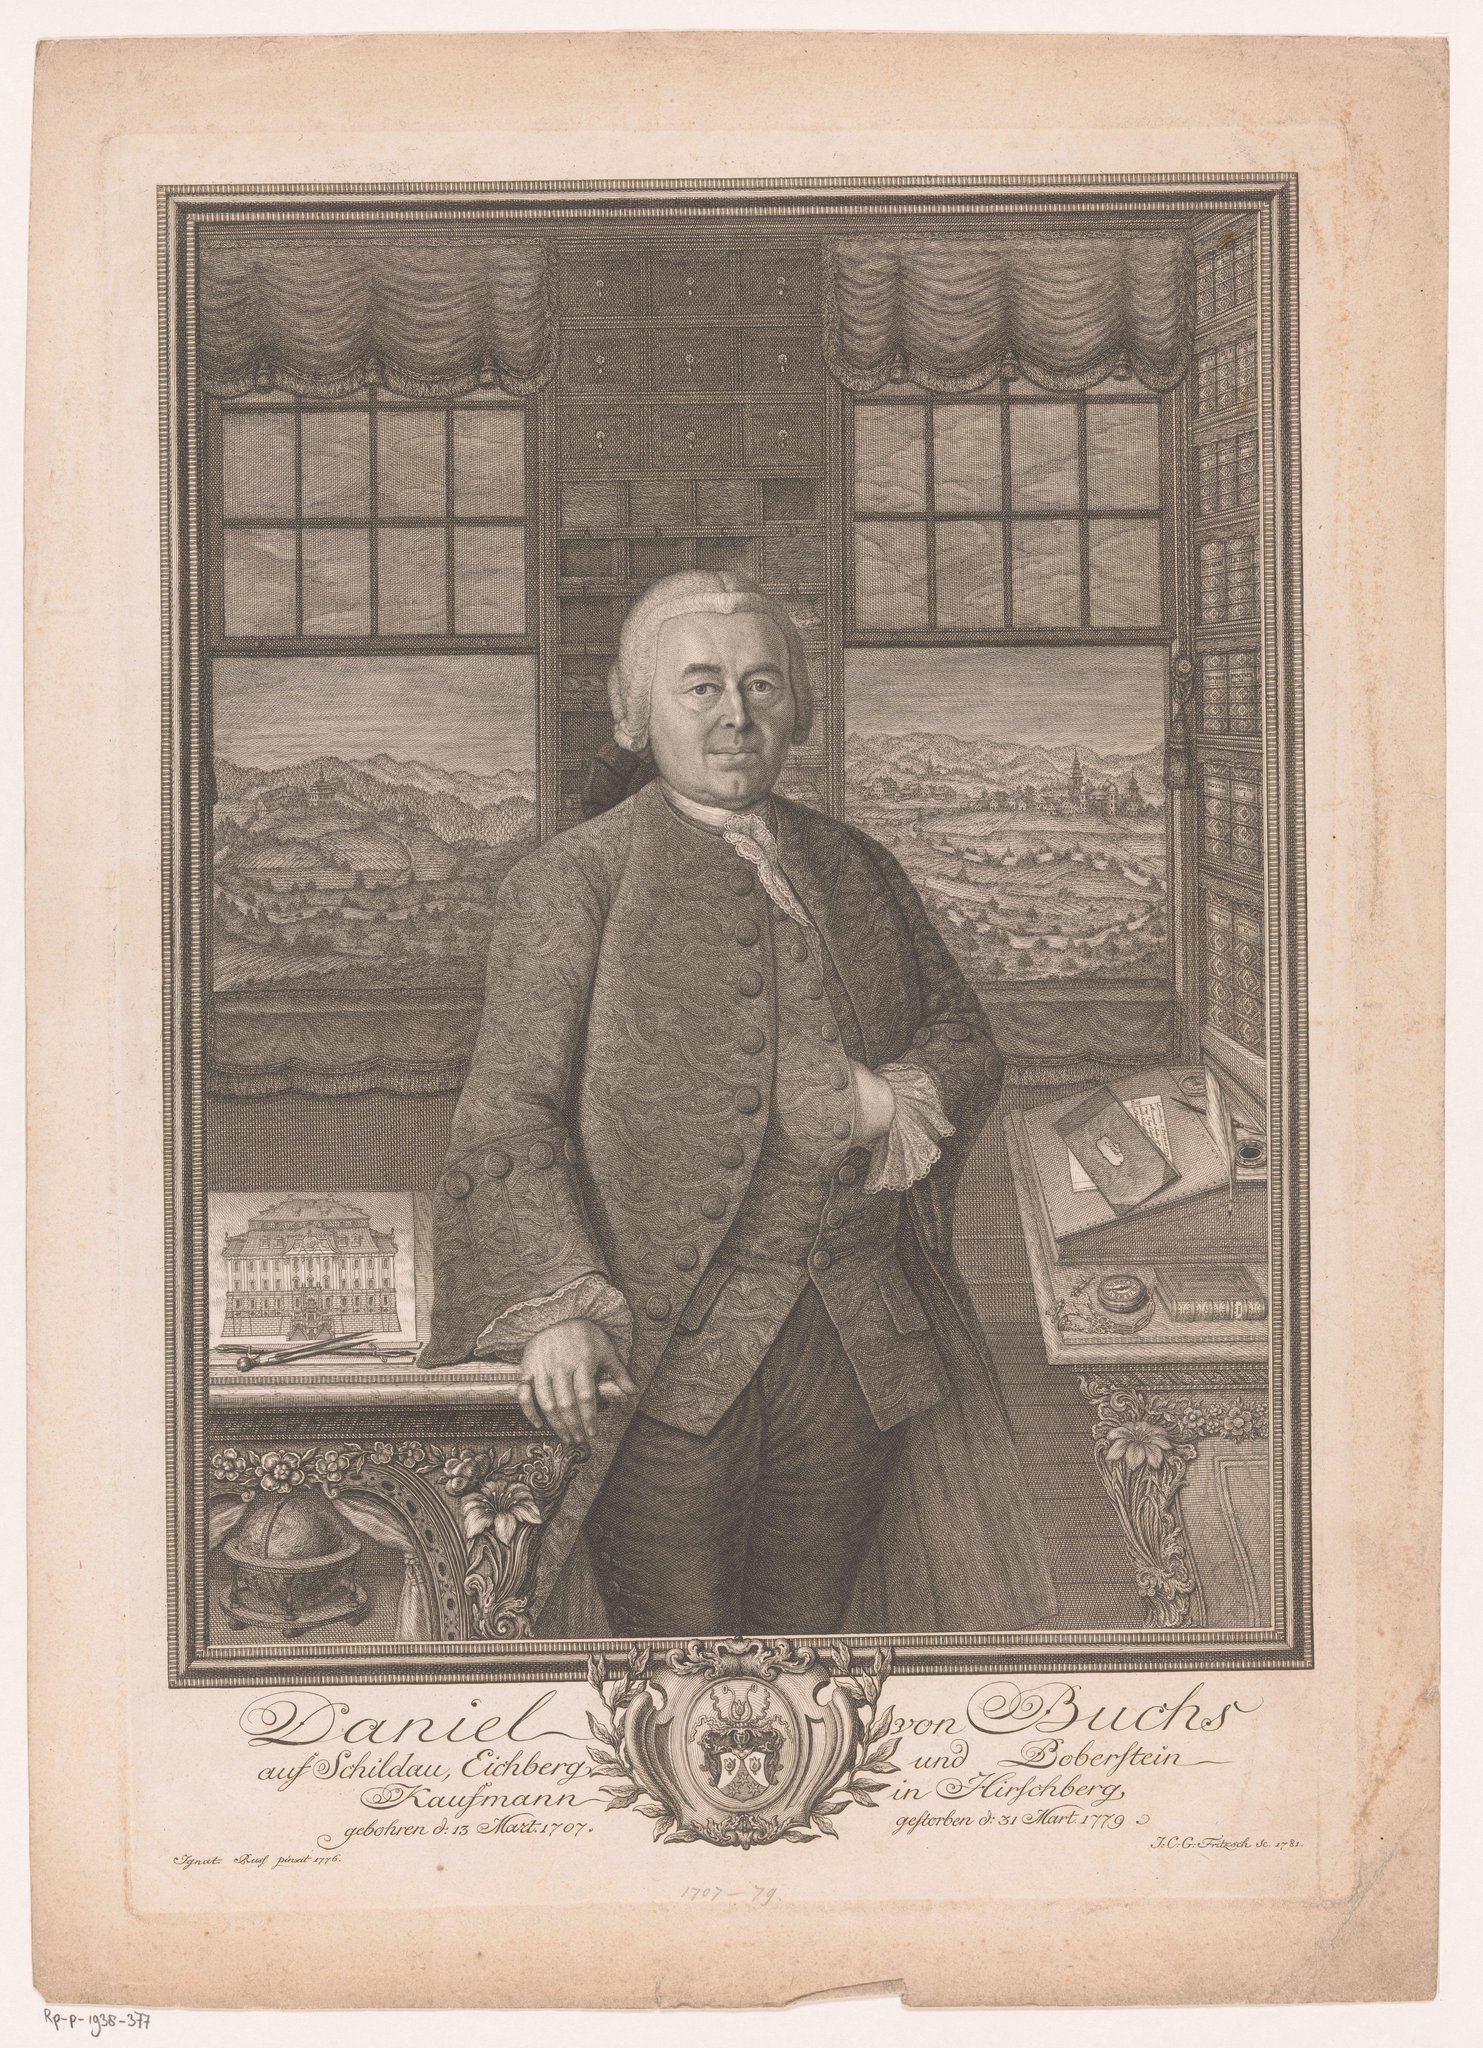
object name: print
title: Portret van Daniel von Buchs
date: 1776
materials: paper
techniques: engraving, etching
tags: landscapes, writing tools, historical persons, study; 'studiolo'; library, globe, watch, tools, implements of architect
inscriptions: collector's mark: Lugt 2228